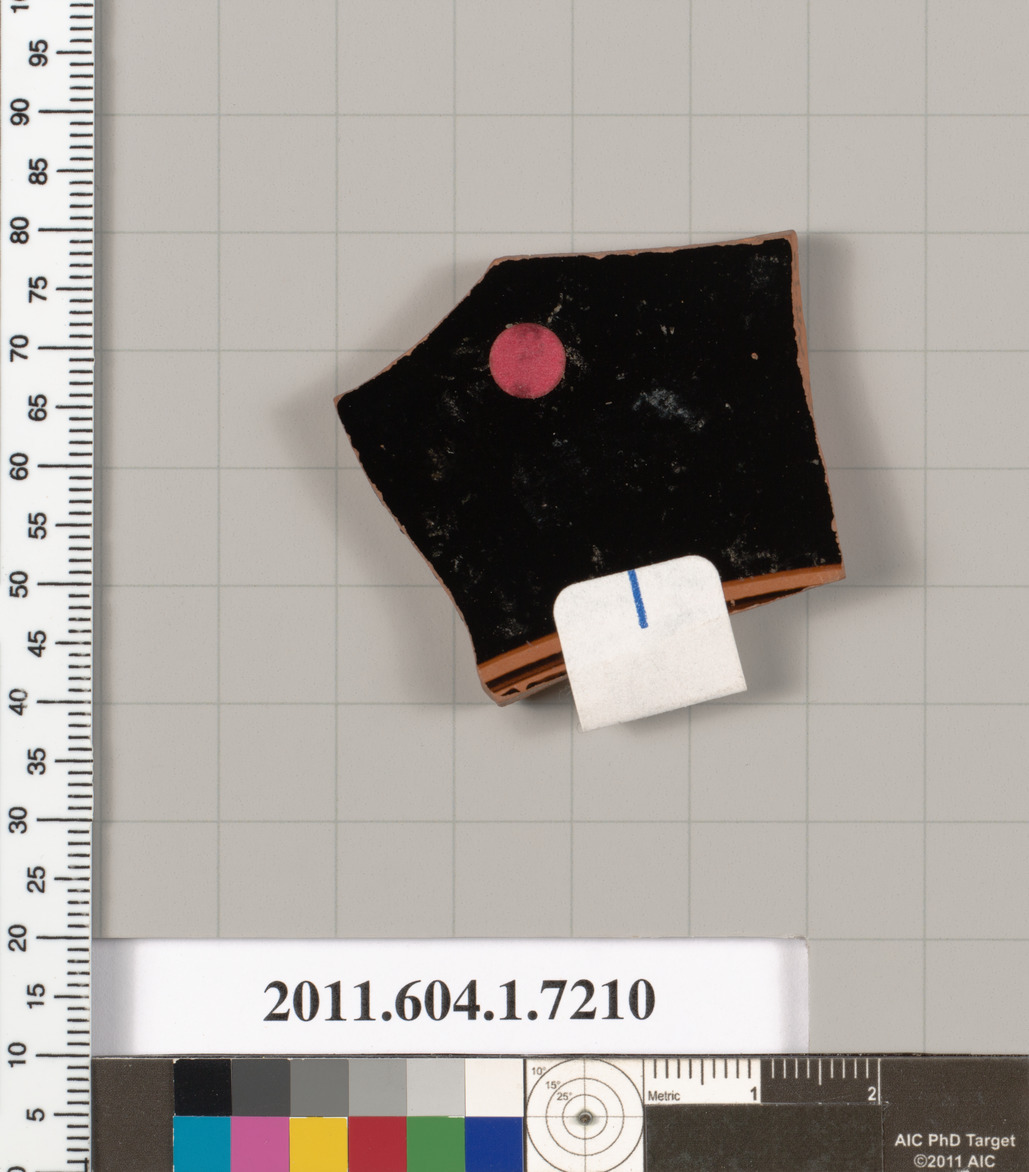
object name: kylix fragment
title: Terracotta fragment of a kylix (drinking cup)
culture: greek, attic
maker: makron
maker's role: artist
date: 500-480 BCE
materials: terracotta